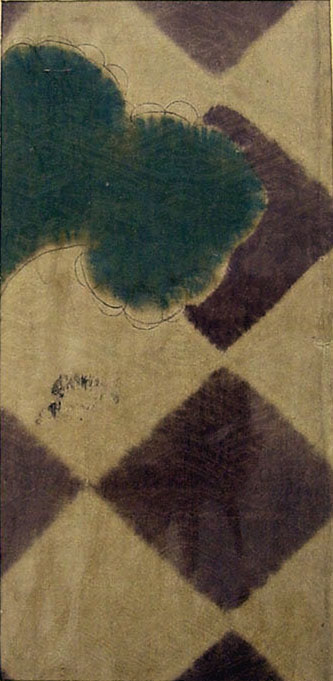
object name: piece from a kosode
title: Piece from a Kosode with Partial Pine Bough on Checked (ishidatami) Background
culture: japanese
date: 1615-1868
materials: silk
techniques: damask, dyeing, resist